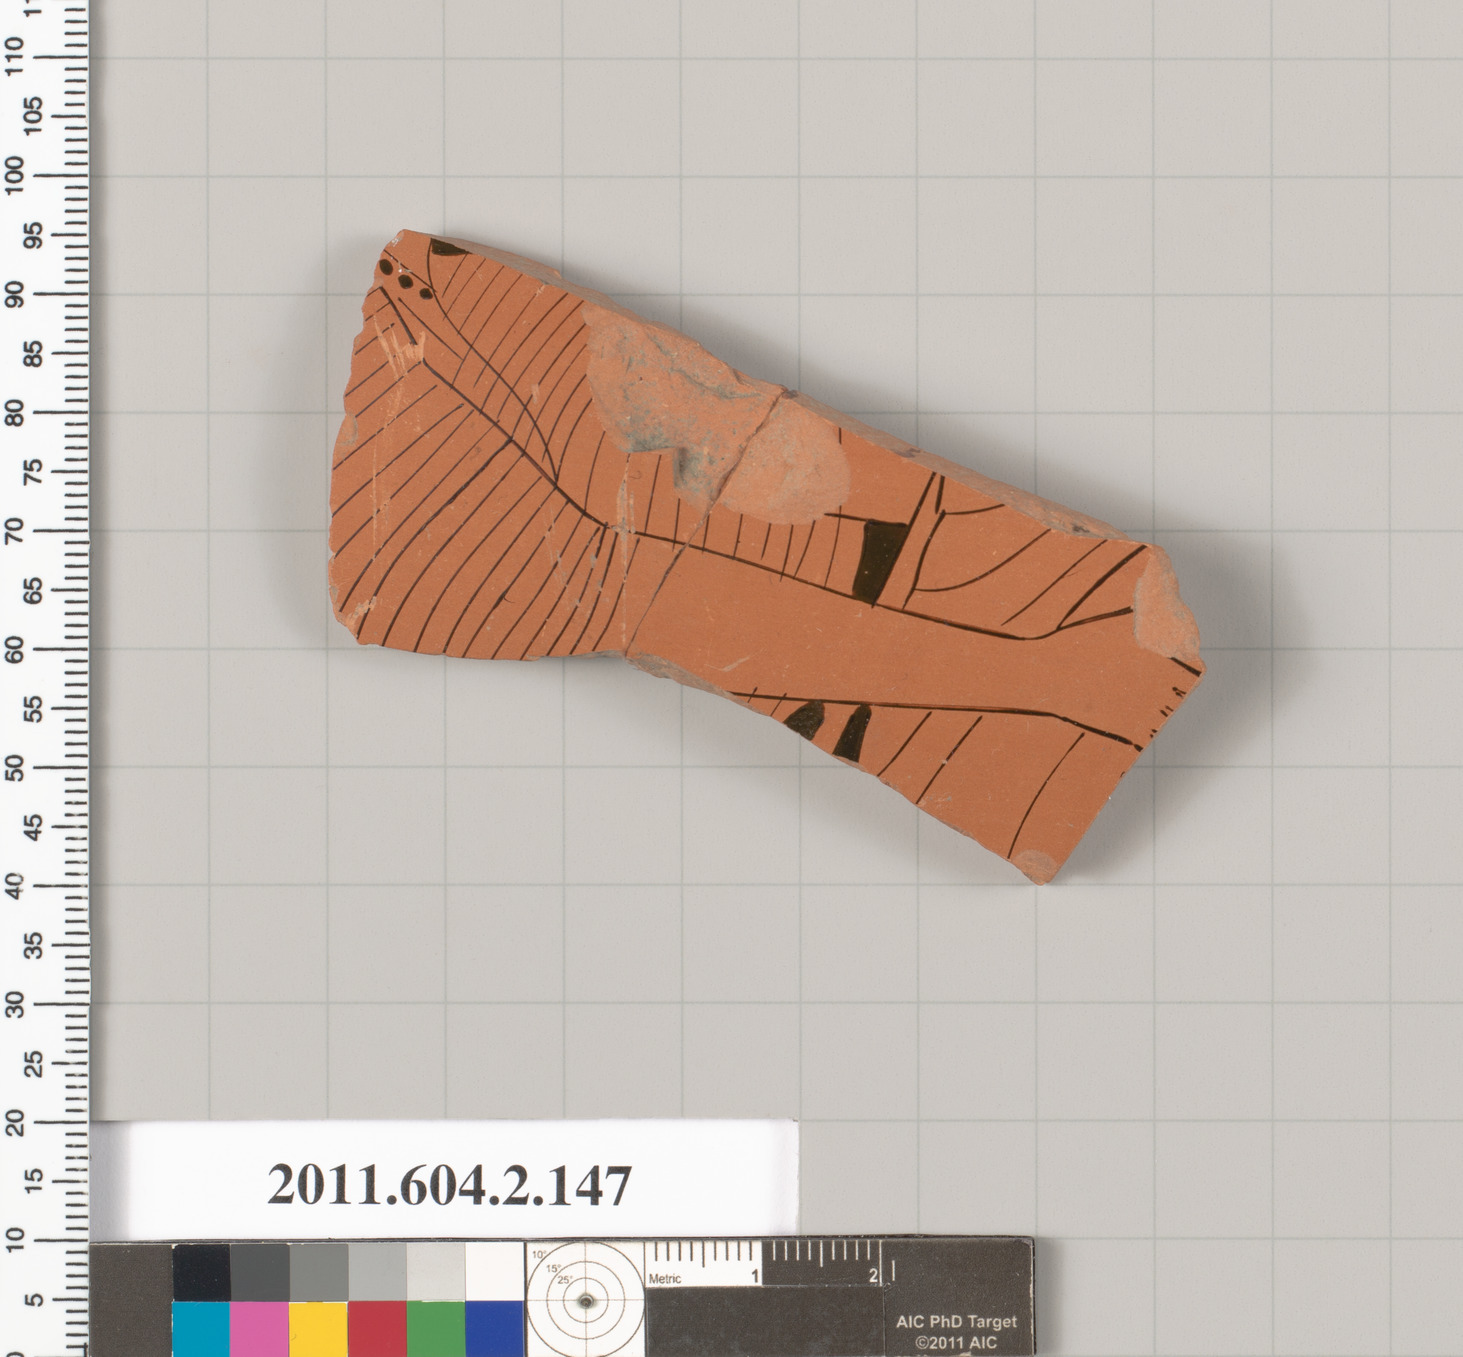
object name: stamnos fragment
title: Terracotta fragment of a stamnos (jar)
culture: greek, attic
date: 470-460 BCE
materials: terracotta